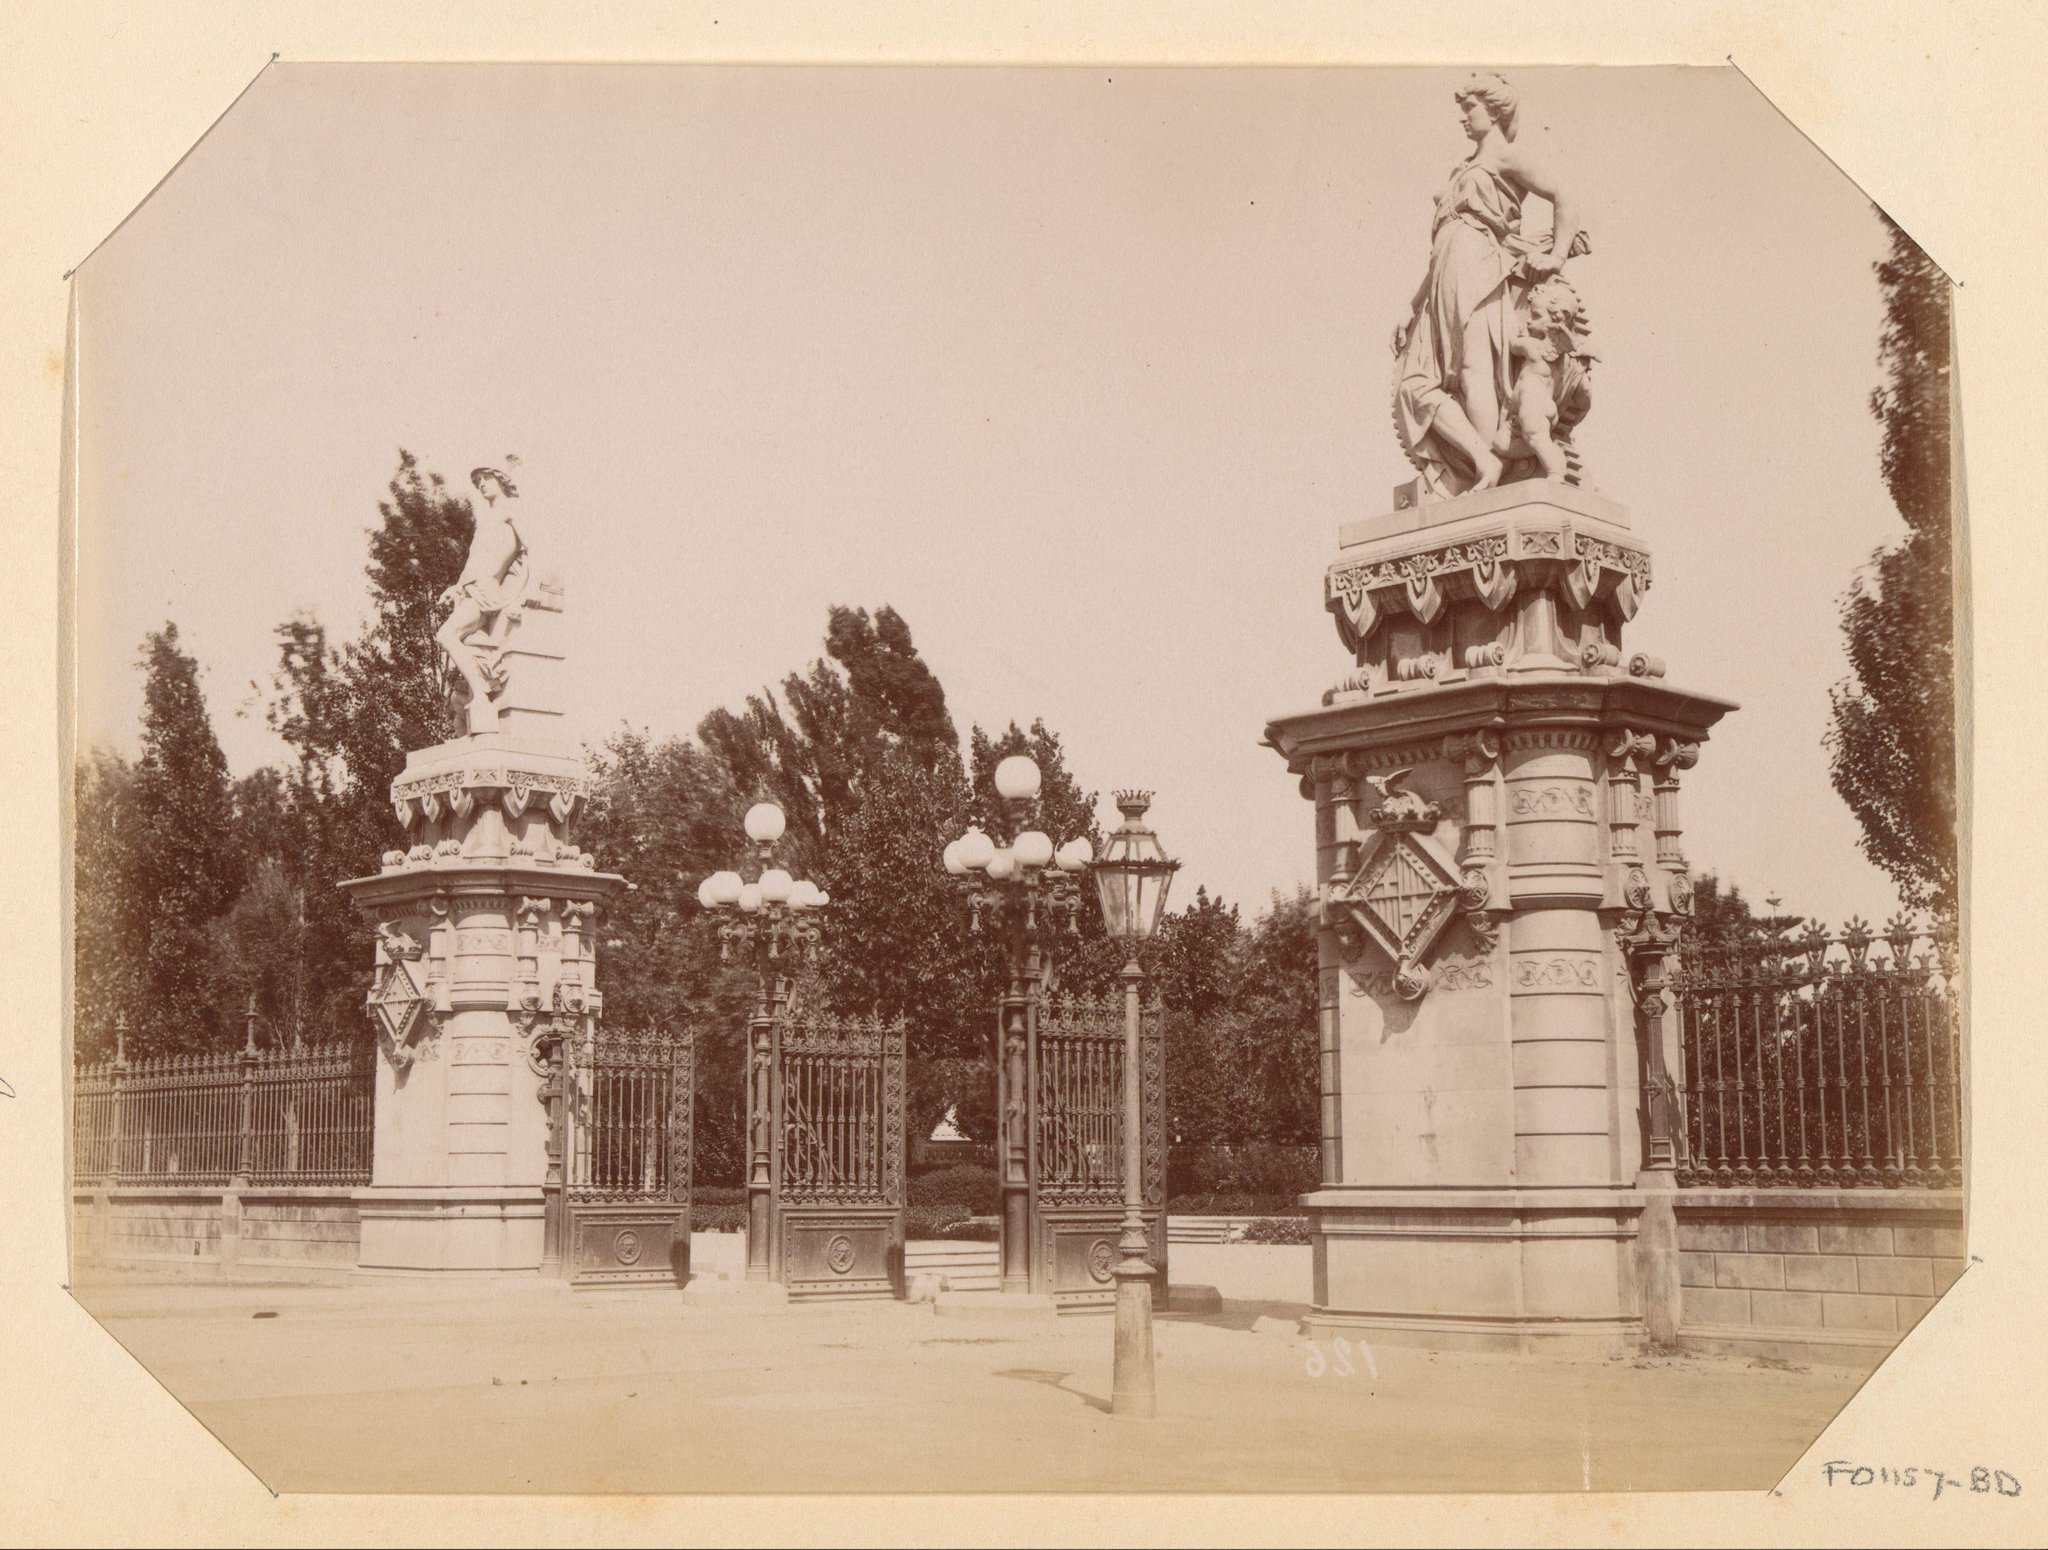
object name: photograph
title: Entree met een hek en twee pilaren met sculpturen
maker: Anonymous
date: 1885-1892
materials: photographic support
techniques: albumen print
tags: gate, entrance, sculpture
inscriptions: annotation: ‘Ingang plantsoen’